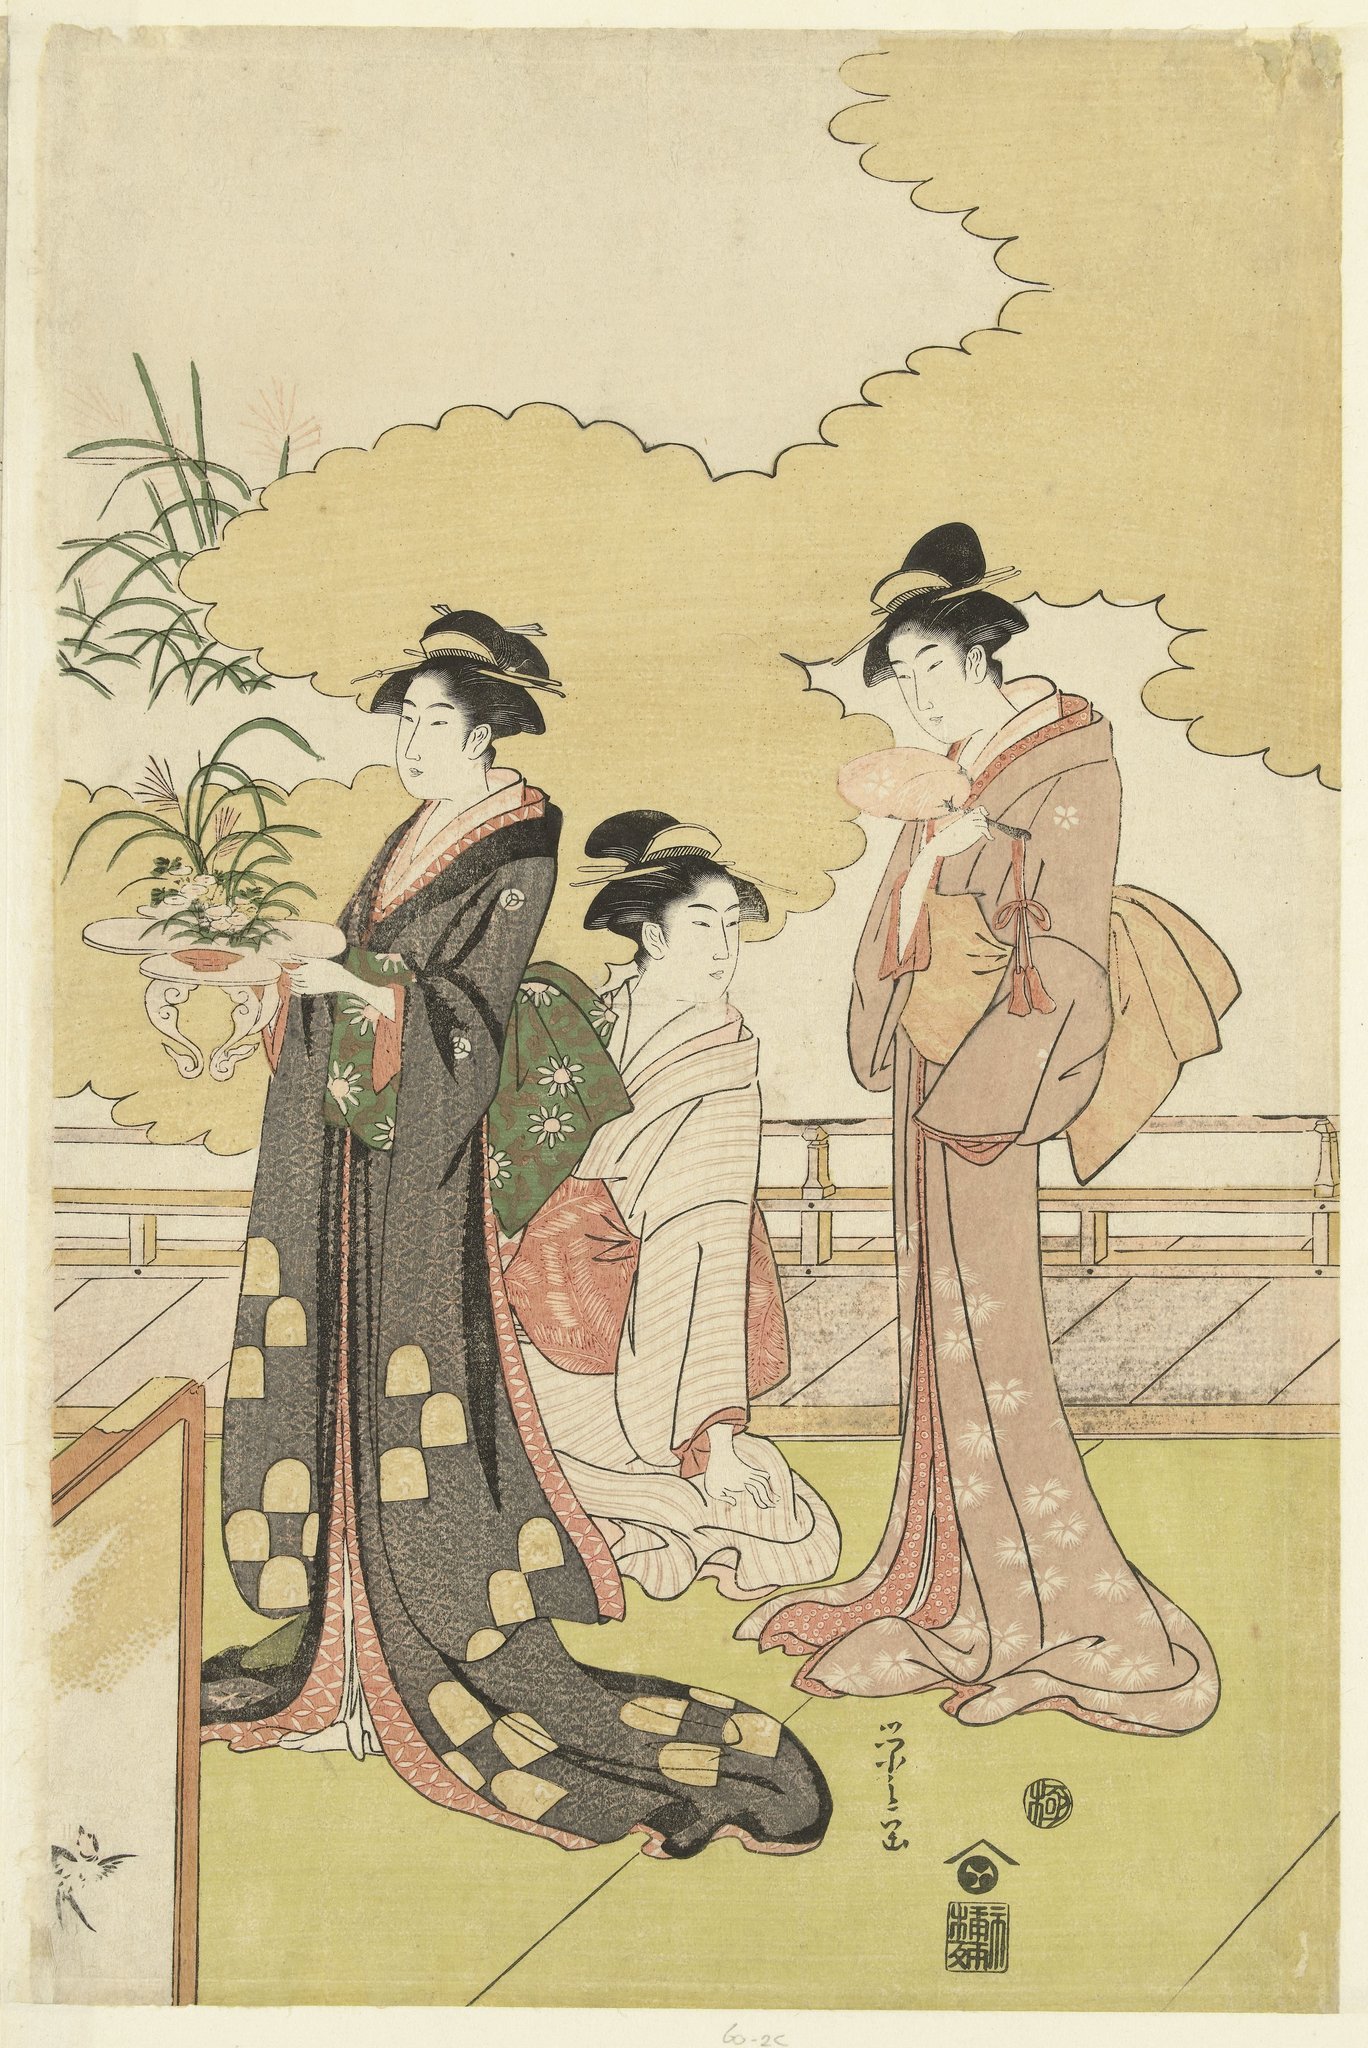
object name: print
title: Vrouwen in een openlucht kamer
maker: hosoda eishi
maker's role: print maker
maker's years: 1756-1829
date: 1793-1797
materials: paper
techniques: woodcut, nishiki e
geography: tokyo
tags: adult woman (+ three persons), loggia, verandah, porch, screen, folding screen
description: Drie vrouwen, één zittend, de andere twee staand met waaier en bloemstuk, in openlucht kamer met veranda en kamerscherm; wolkpatroon op de achtergrond.